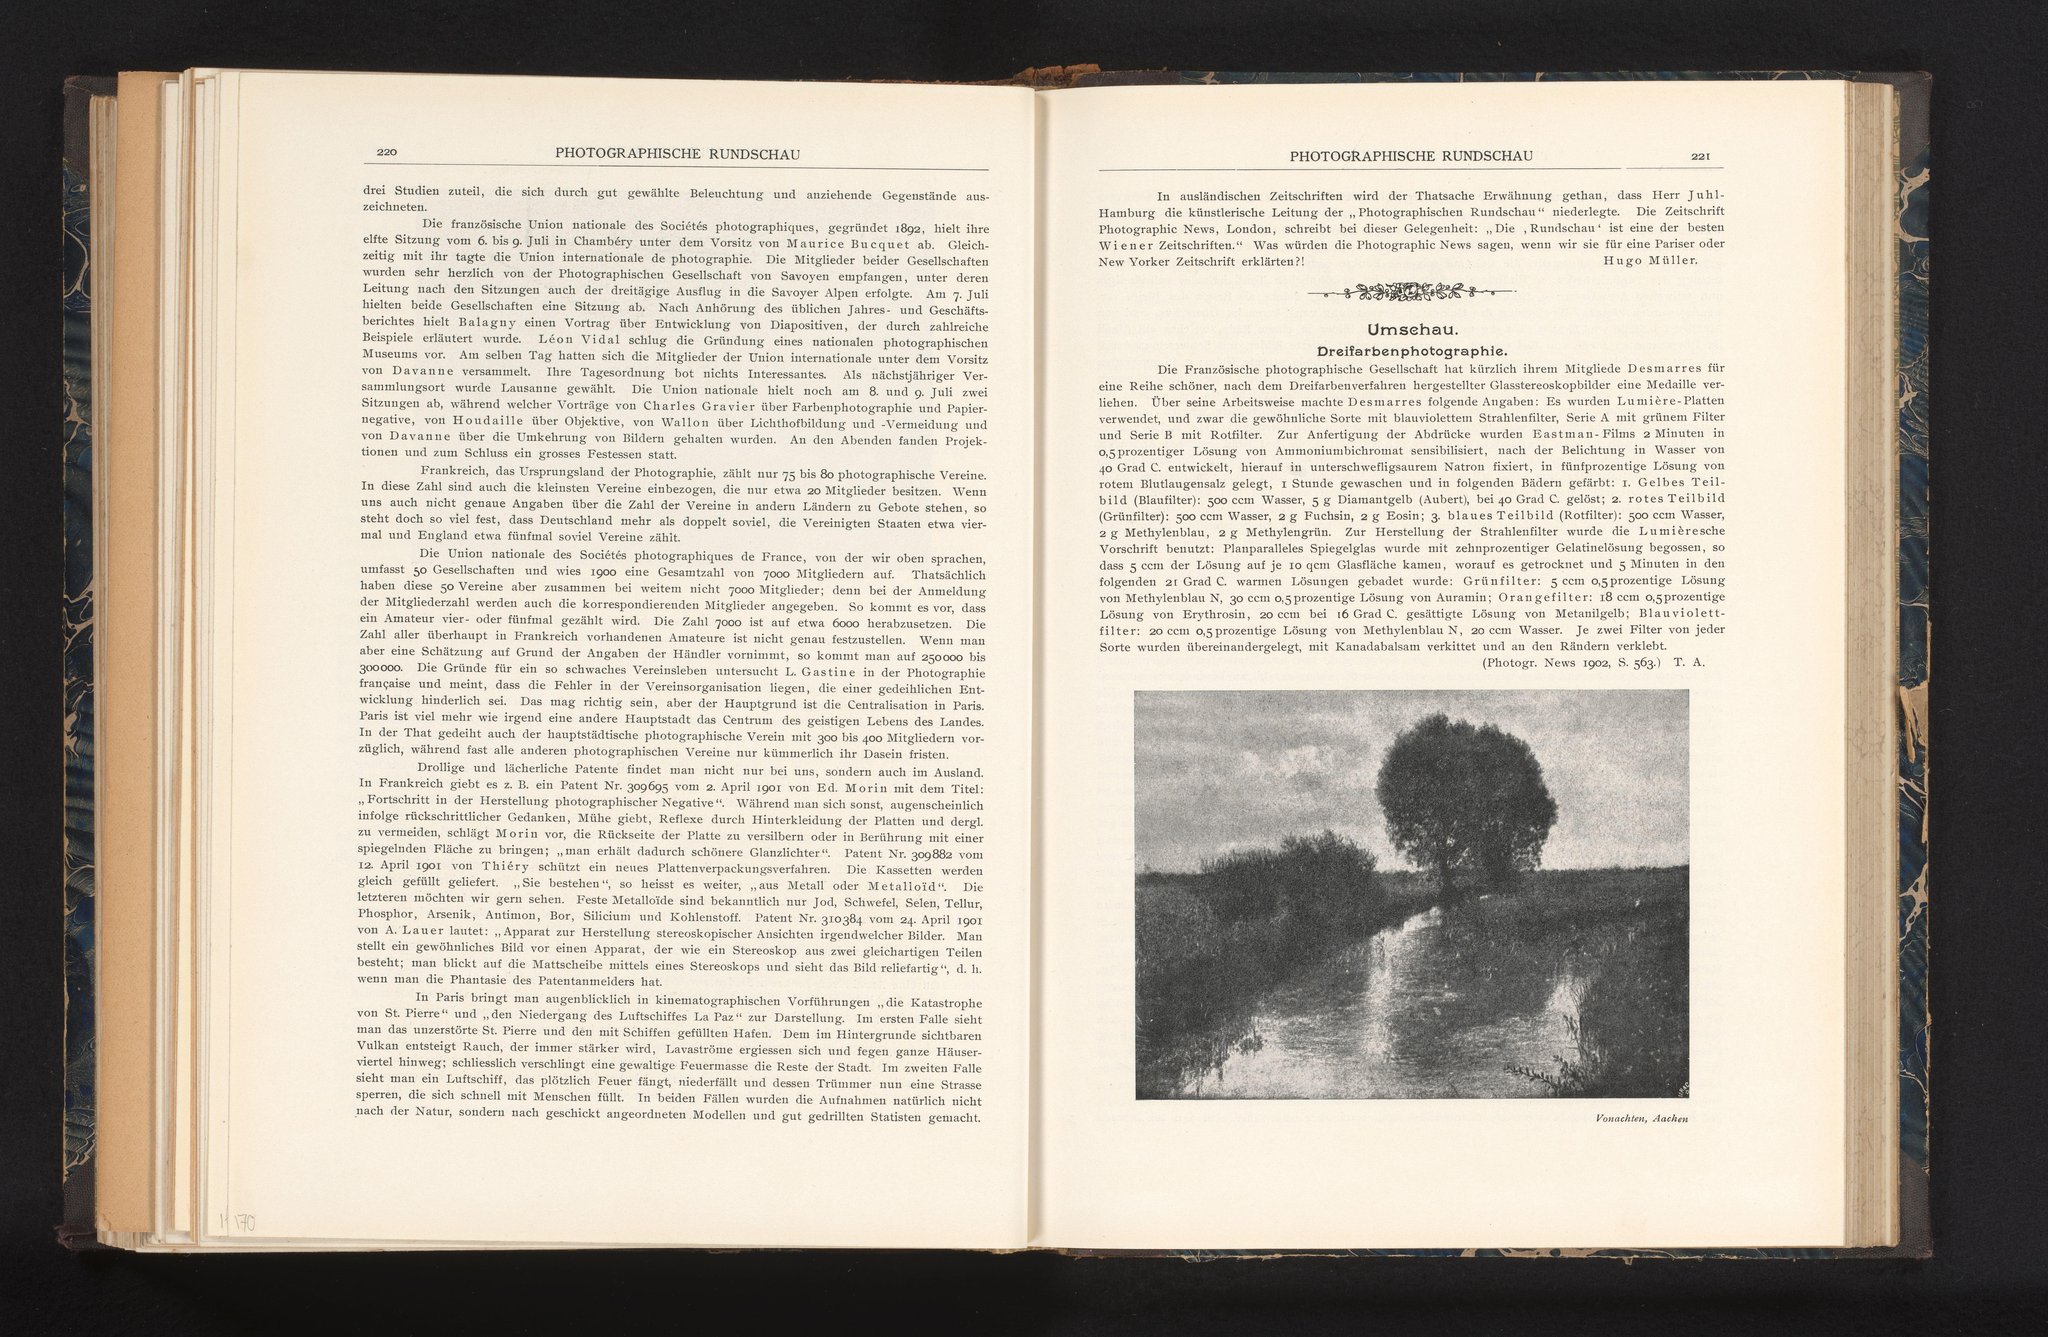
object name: page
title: Gezicht op bomen aan een water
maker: h. vonachten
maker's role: fotograaf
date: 1897-1902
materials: paper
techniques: autotype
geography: berlin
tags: trees, landscapes with waters, waterscapes, seascapes (in the temperate zone)